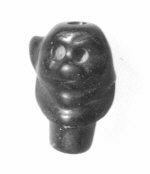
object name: bead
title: Bead in the shape of Pazuzu head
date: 1000-1 BCE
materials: stone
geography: cyprus